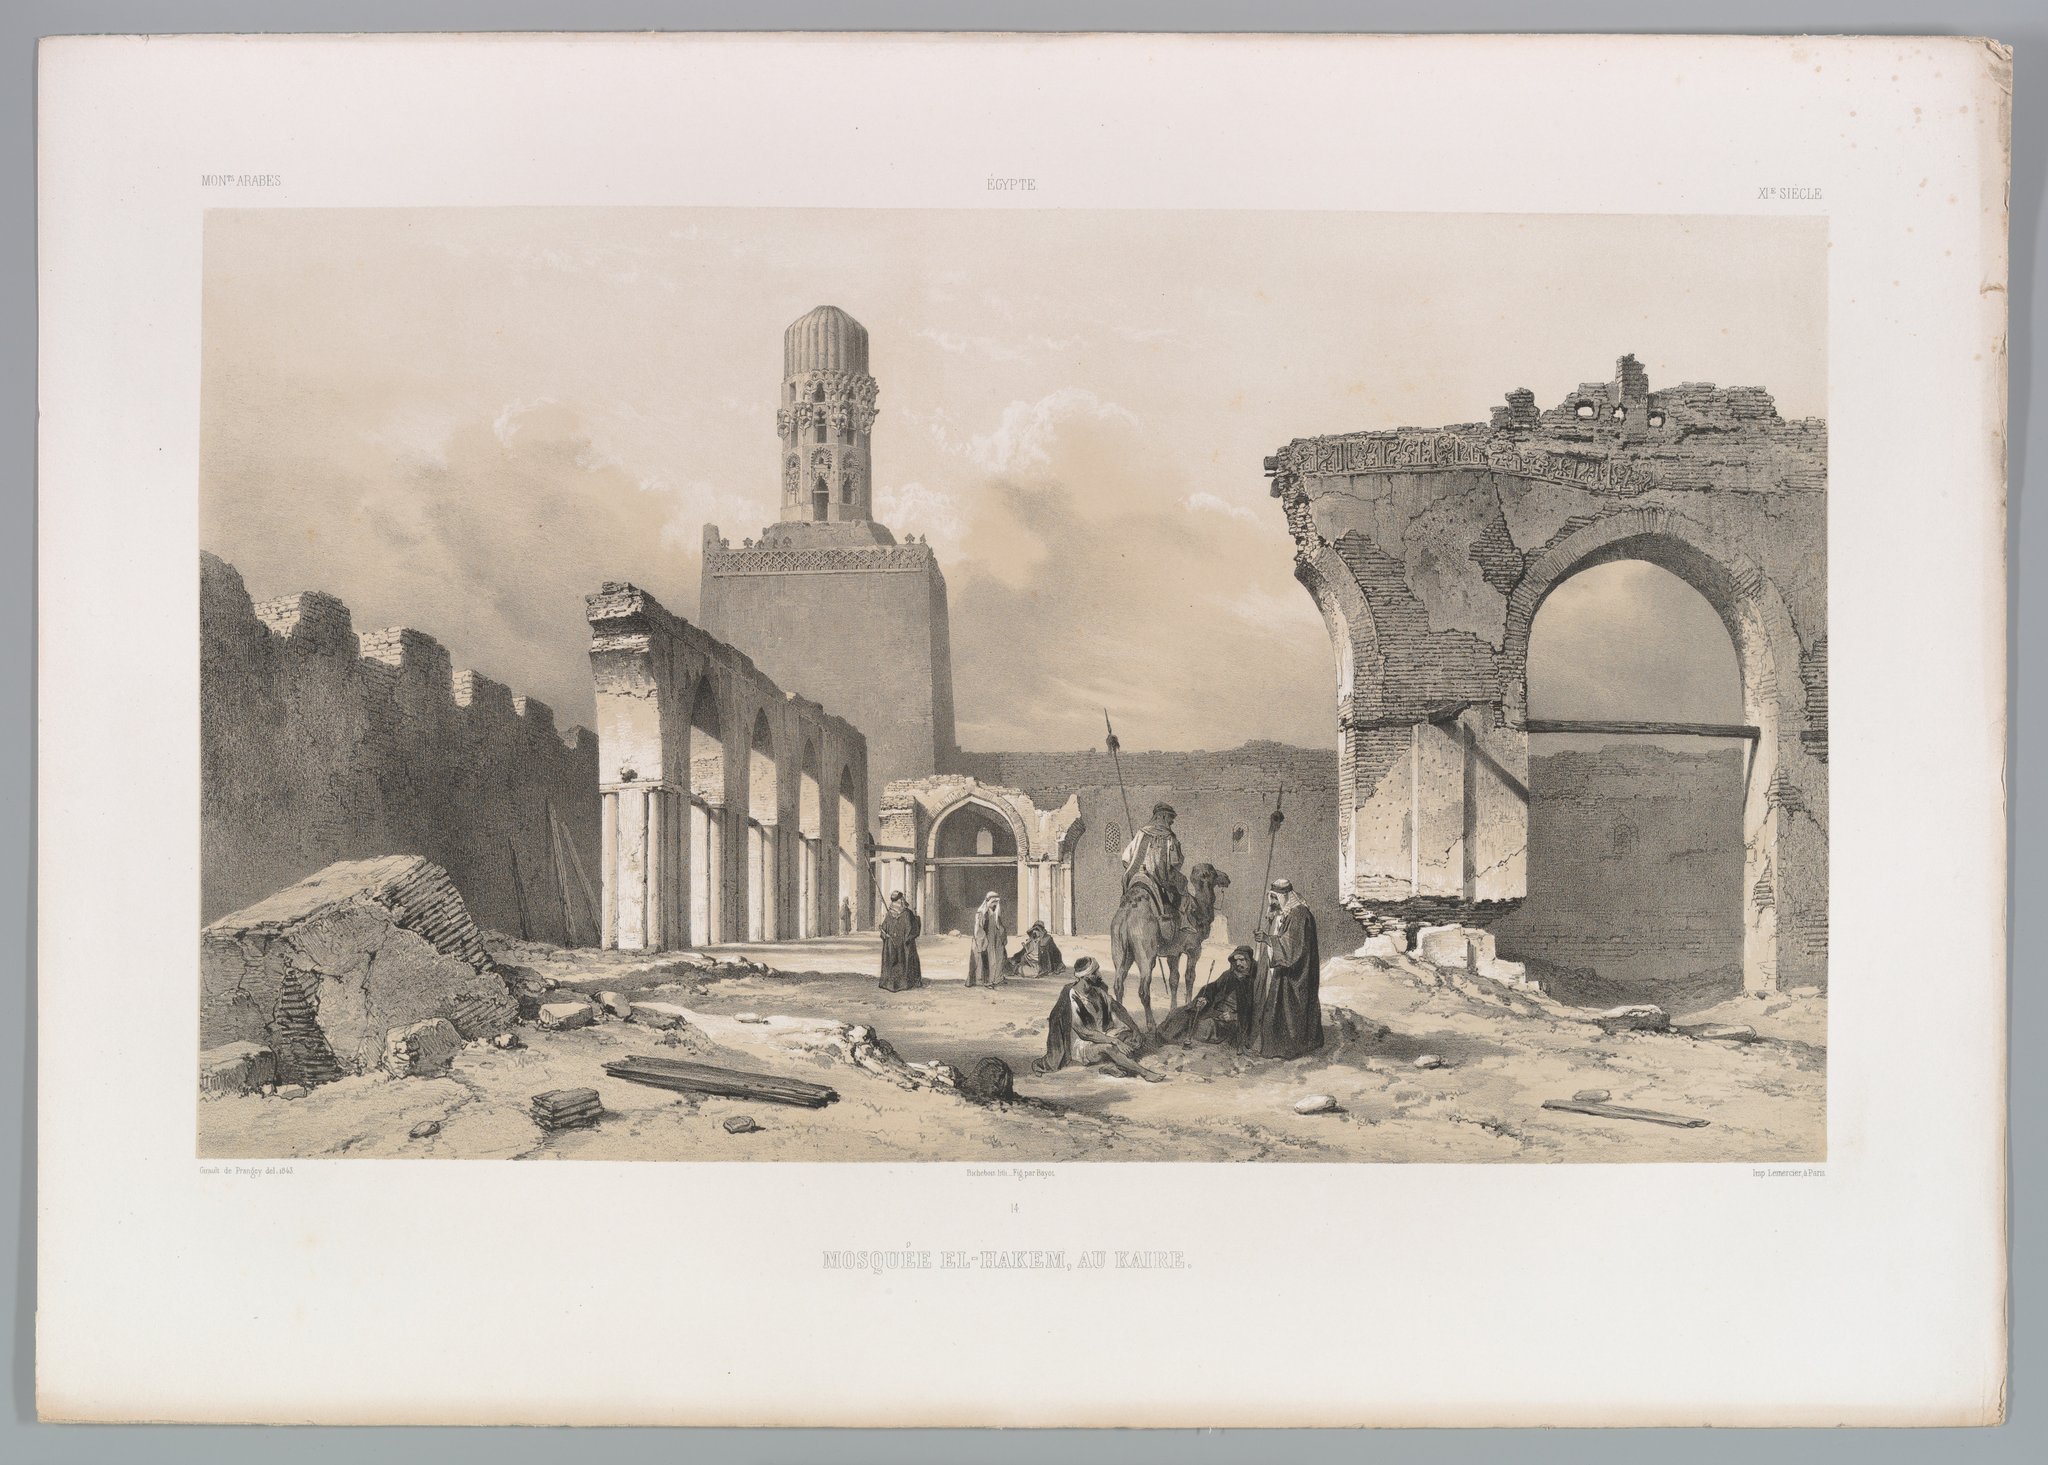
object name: lithograph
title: 14. Mosquée el Hakem, au Kaire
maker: joseph-philibert girault de prangey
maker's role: artist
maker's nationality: french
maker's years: 1804-1892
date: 1843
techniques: lithograph